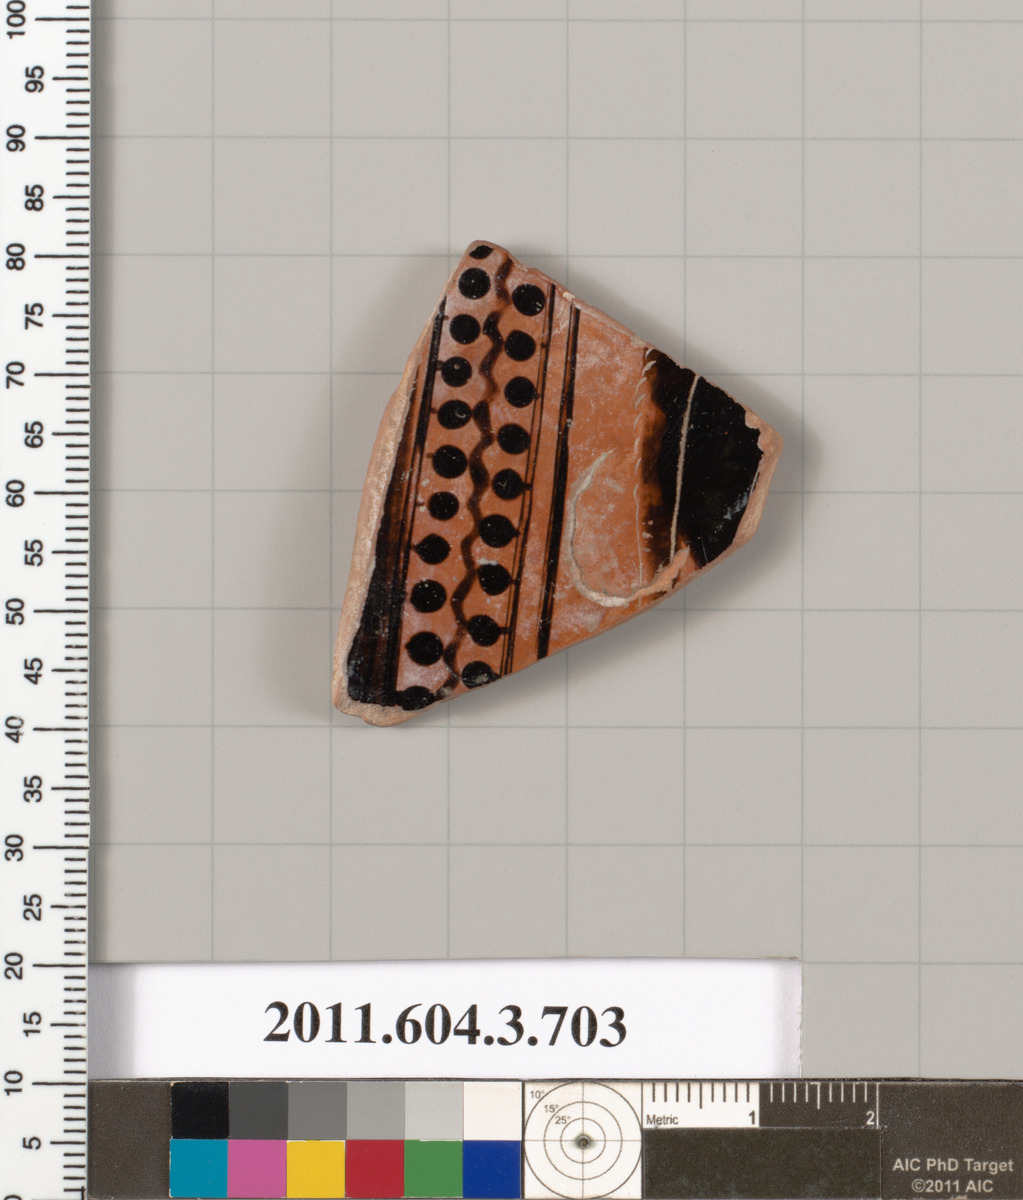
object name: hydria fragment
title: Terracotta fragment of a hydria (water jar)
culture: greek, attic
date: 534-468 BCE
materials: terracotta